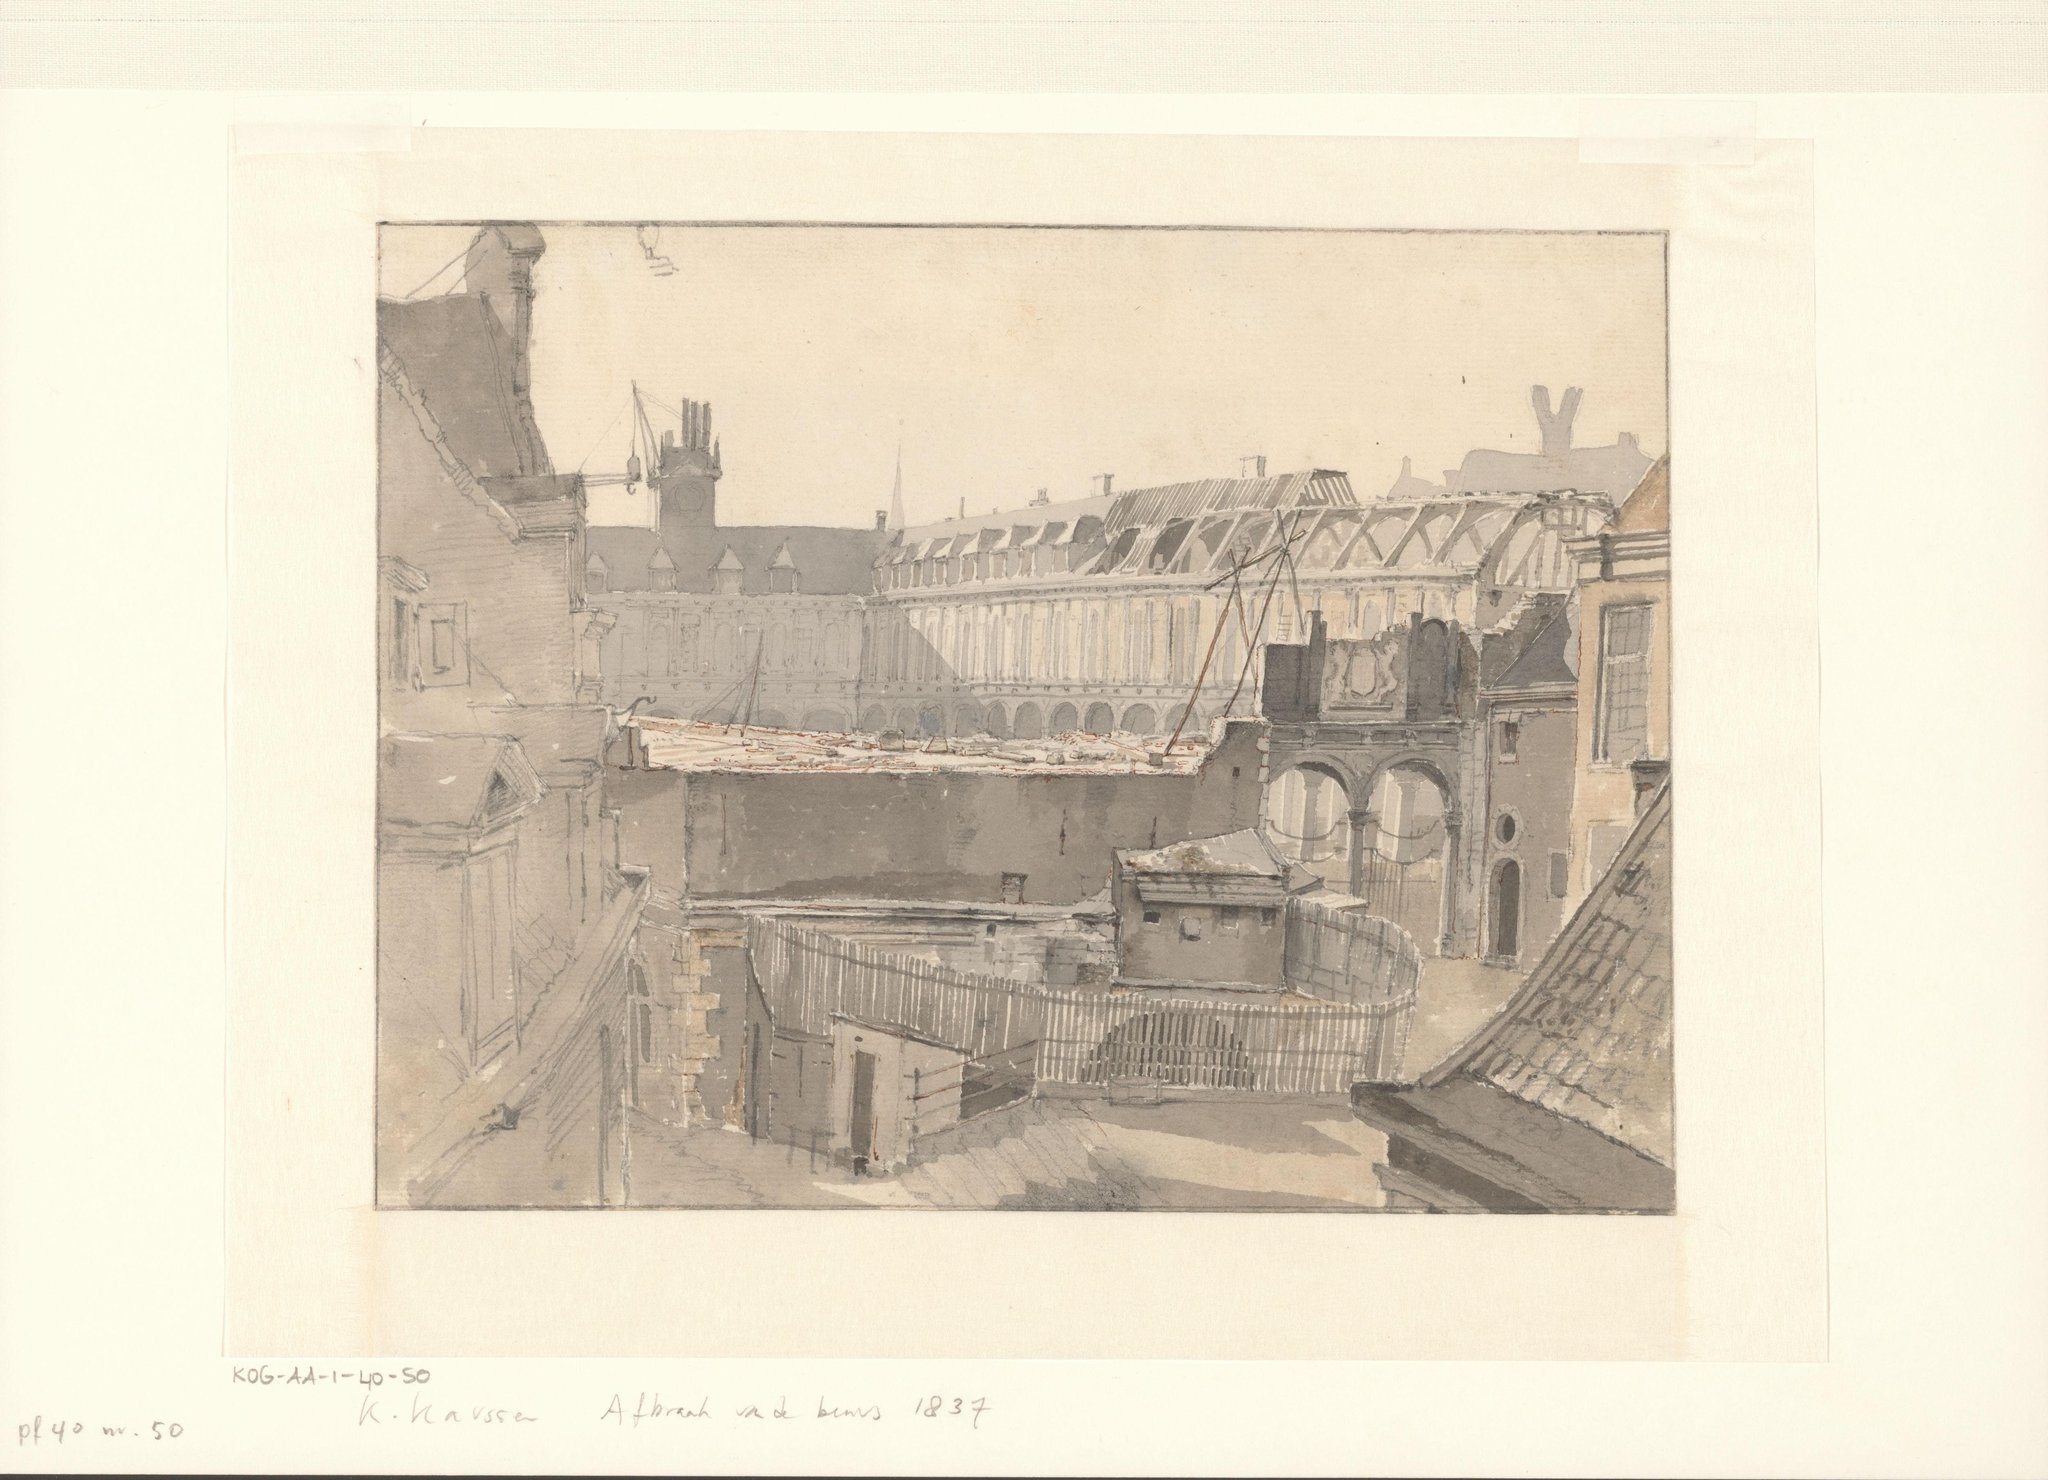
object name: drawing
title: Gezicht op de sloop van de beurs van Hendrik de Keyser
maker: kasparus karsen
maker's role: draughtsman, painter, print maker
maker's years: 1810-1896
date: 1803-1837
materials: ink, paper, pencil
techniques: brush, pen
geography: amsterdam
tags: city-view in general; 'veduta', stock exchange, stock-market, demolition of building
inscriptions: inscription: ‘Bij het verblyf (...) lo[...]on / betaling / 1814.’, signature, date and inscription: ‘Schets van de (...) Maart 1837 K Karsen’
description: Onderwerpsrubriek binnen de Atlas Amsterdam: Beurs op het Rokin.